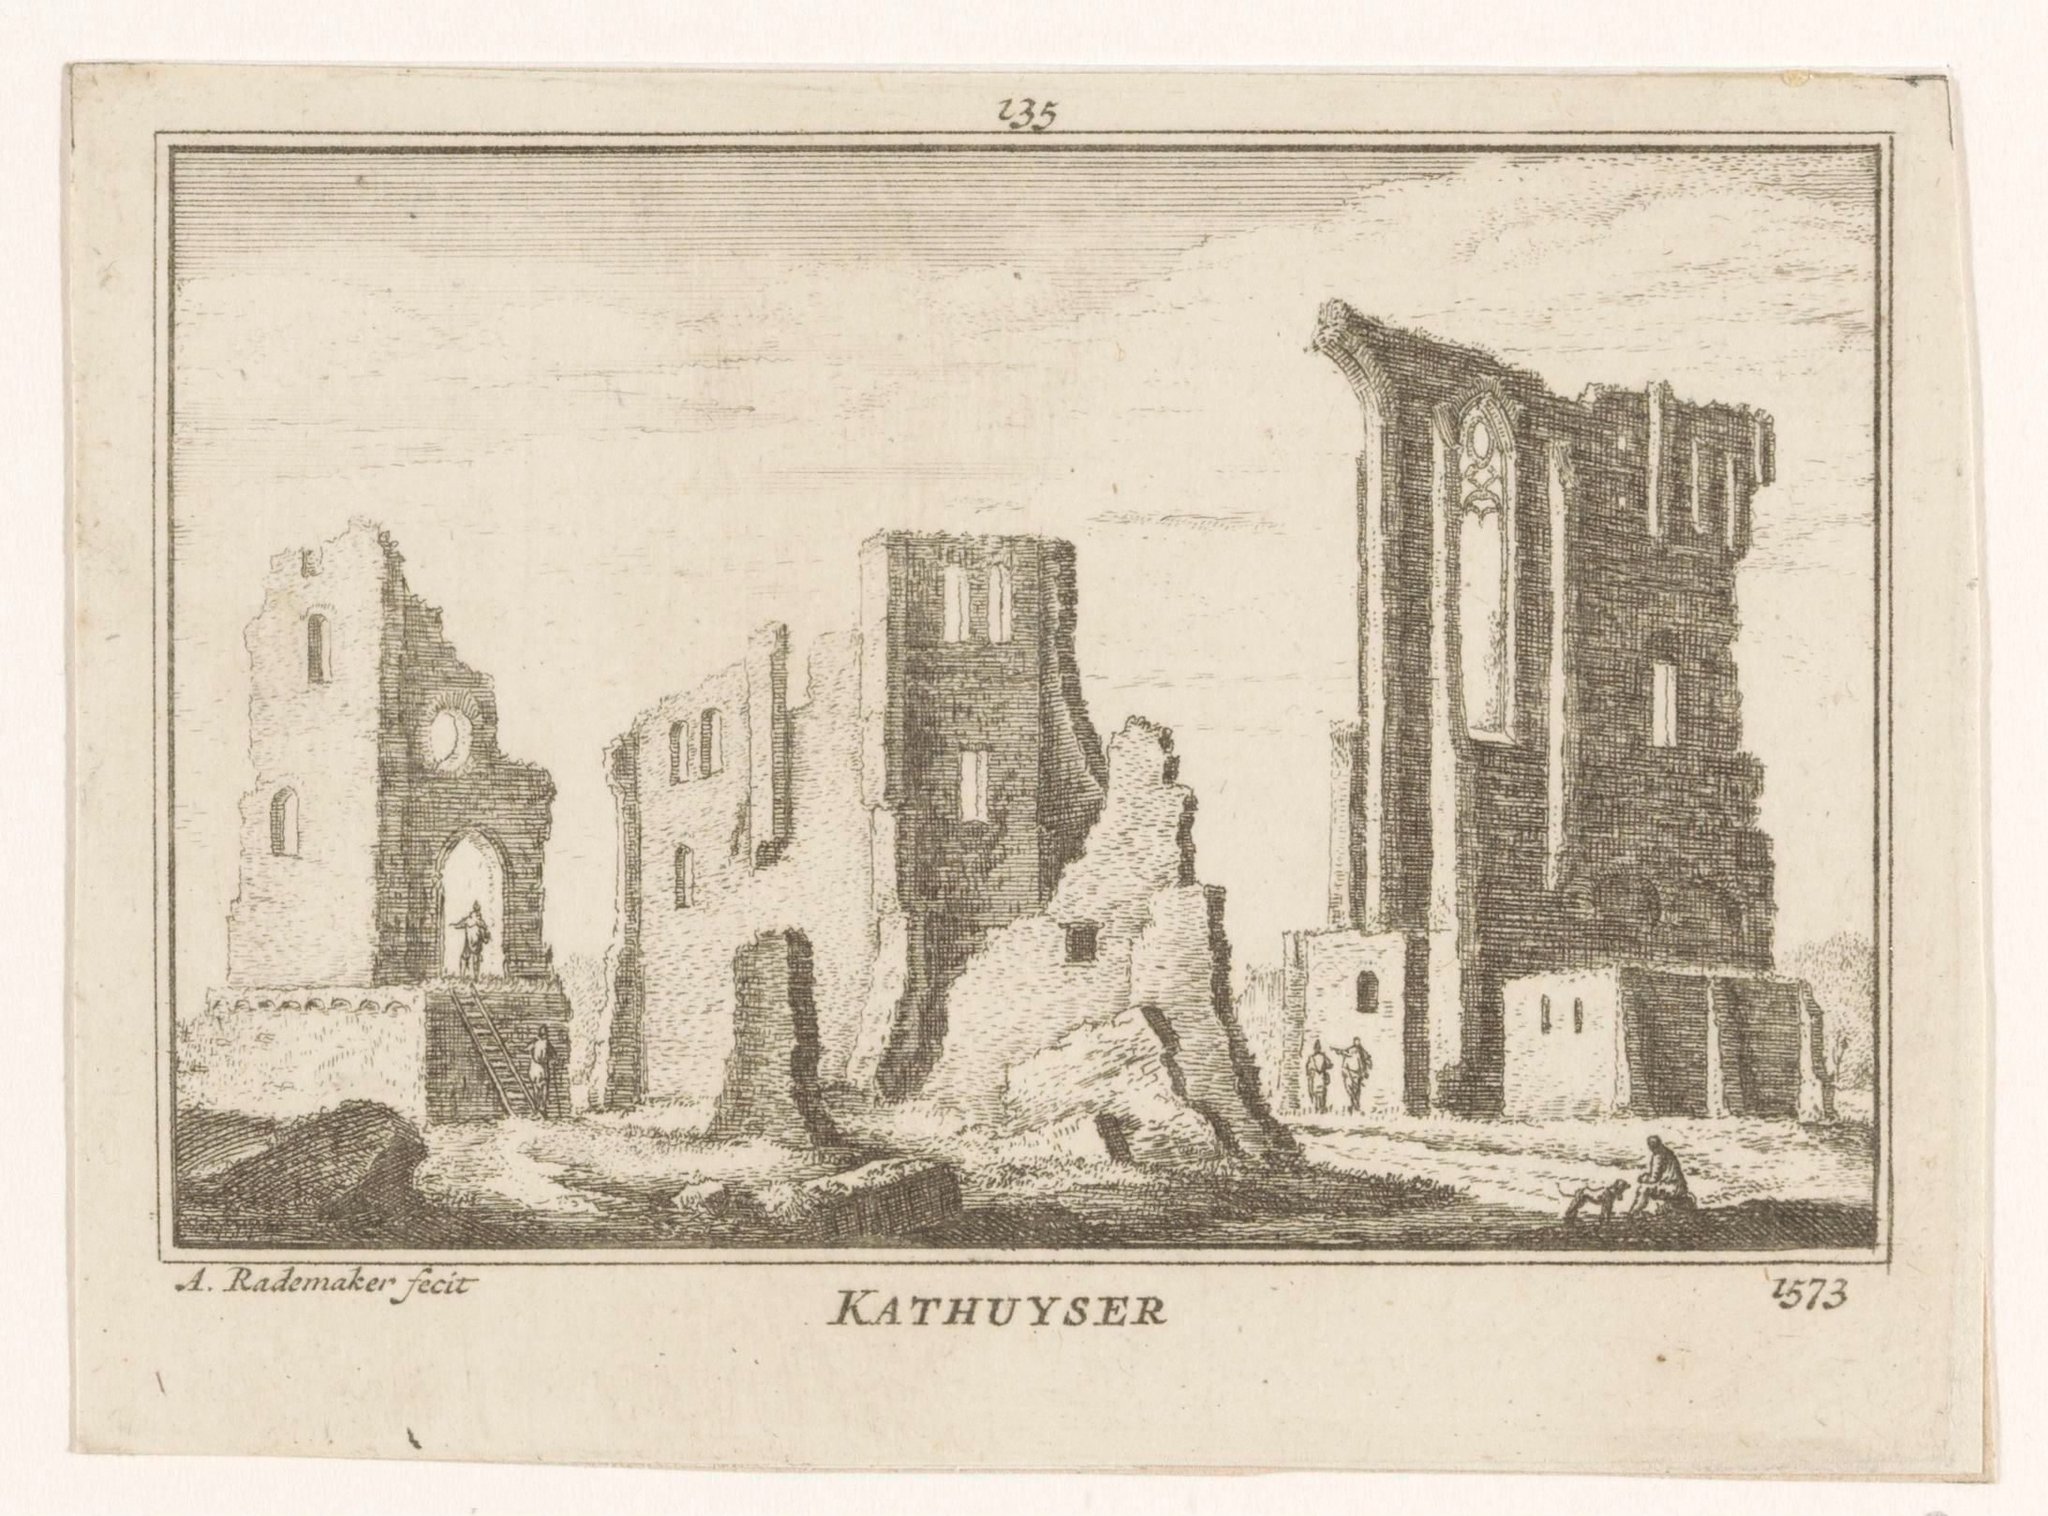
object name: book illustration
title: Gezicht op de ruïne van het kartuizerklooster bij Delft, 1573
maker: abraham rademaker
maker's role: draughtsman, print maker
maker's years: 1676-1735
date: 1725-1803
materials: paper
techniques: engraving, etching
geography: amsterdam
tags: ruin of church, monastery, etc., dog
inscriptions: collector's mark: Lugt 2228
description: Prent ook gebruikt in: Rademaker, Abraham. Kabinet van Nederlandsche outheden en gezichten: vervat in 300 konstplaaten (…). 2 delen. Amsterdam: Willem Barents, 1725, dl. 1, ill. 135. Na 1725 is deze prent nog in verschillende heruitgaven verschenen, uitgegeven in 1727-1733, 1770-1771 en 1792-1803. Uit welke uitgave het huidige exemplaar precies komt is niet na te gaan.